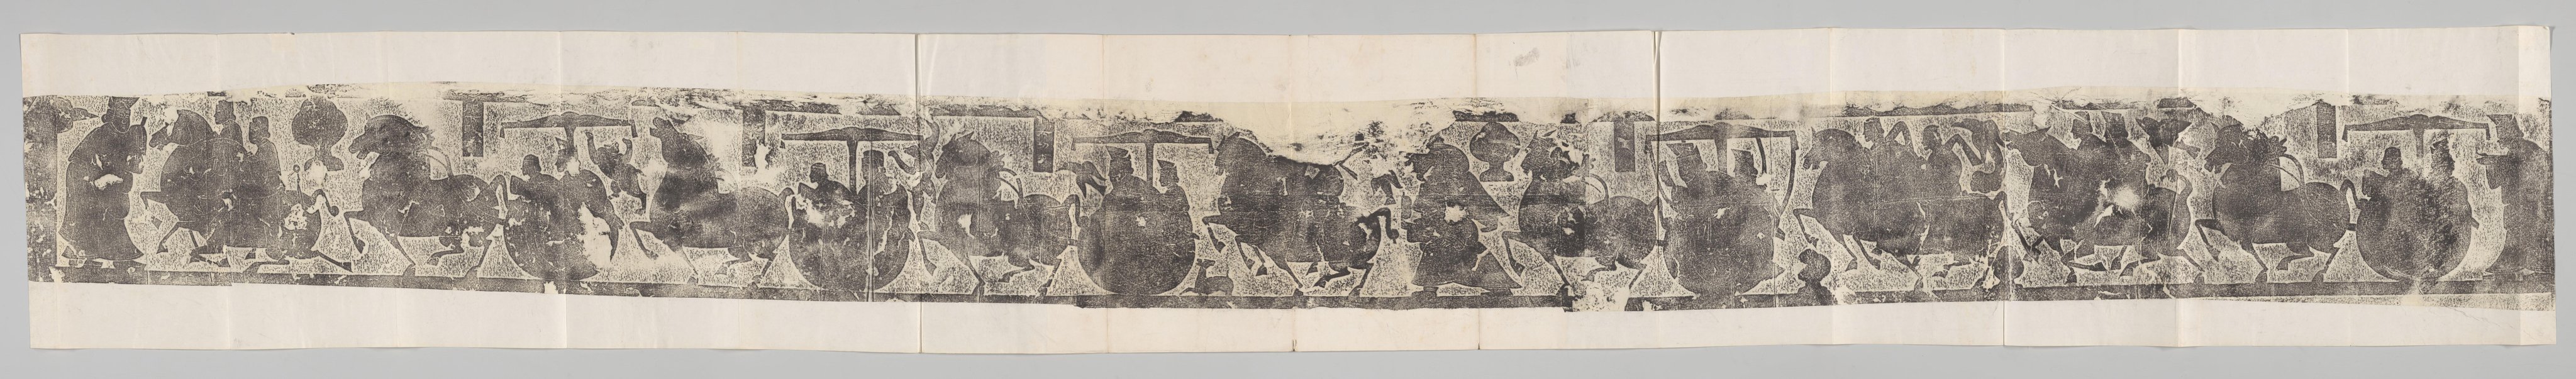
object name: wrijfprent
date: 1900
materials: ink, paper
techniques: rubbing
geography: china